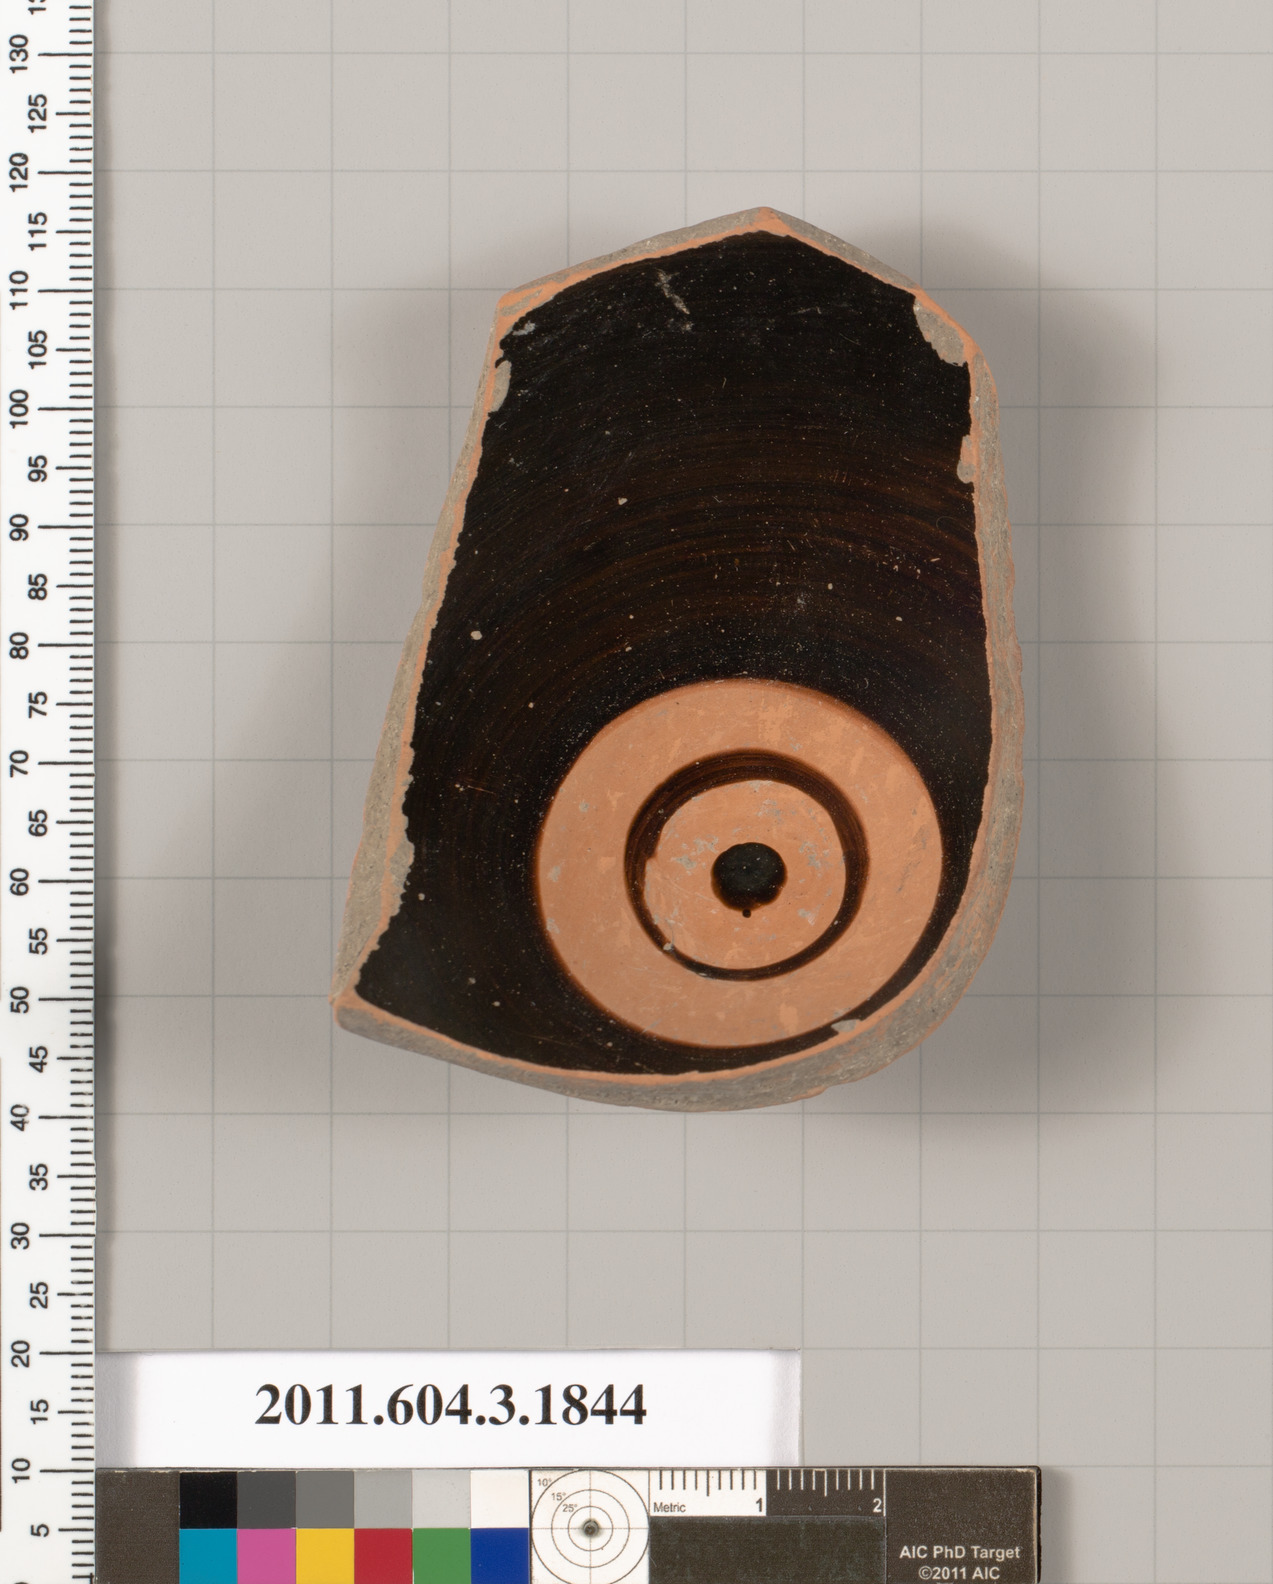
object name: kylix fragment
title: Terracotta fragment of a kylix: Lip cup (drinking cup)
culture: greek, attic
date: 567-535 BCE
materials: terracotta